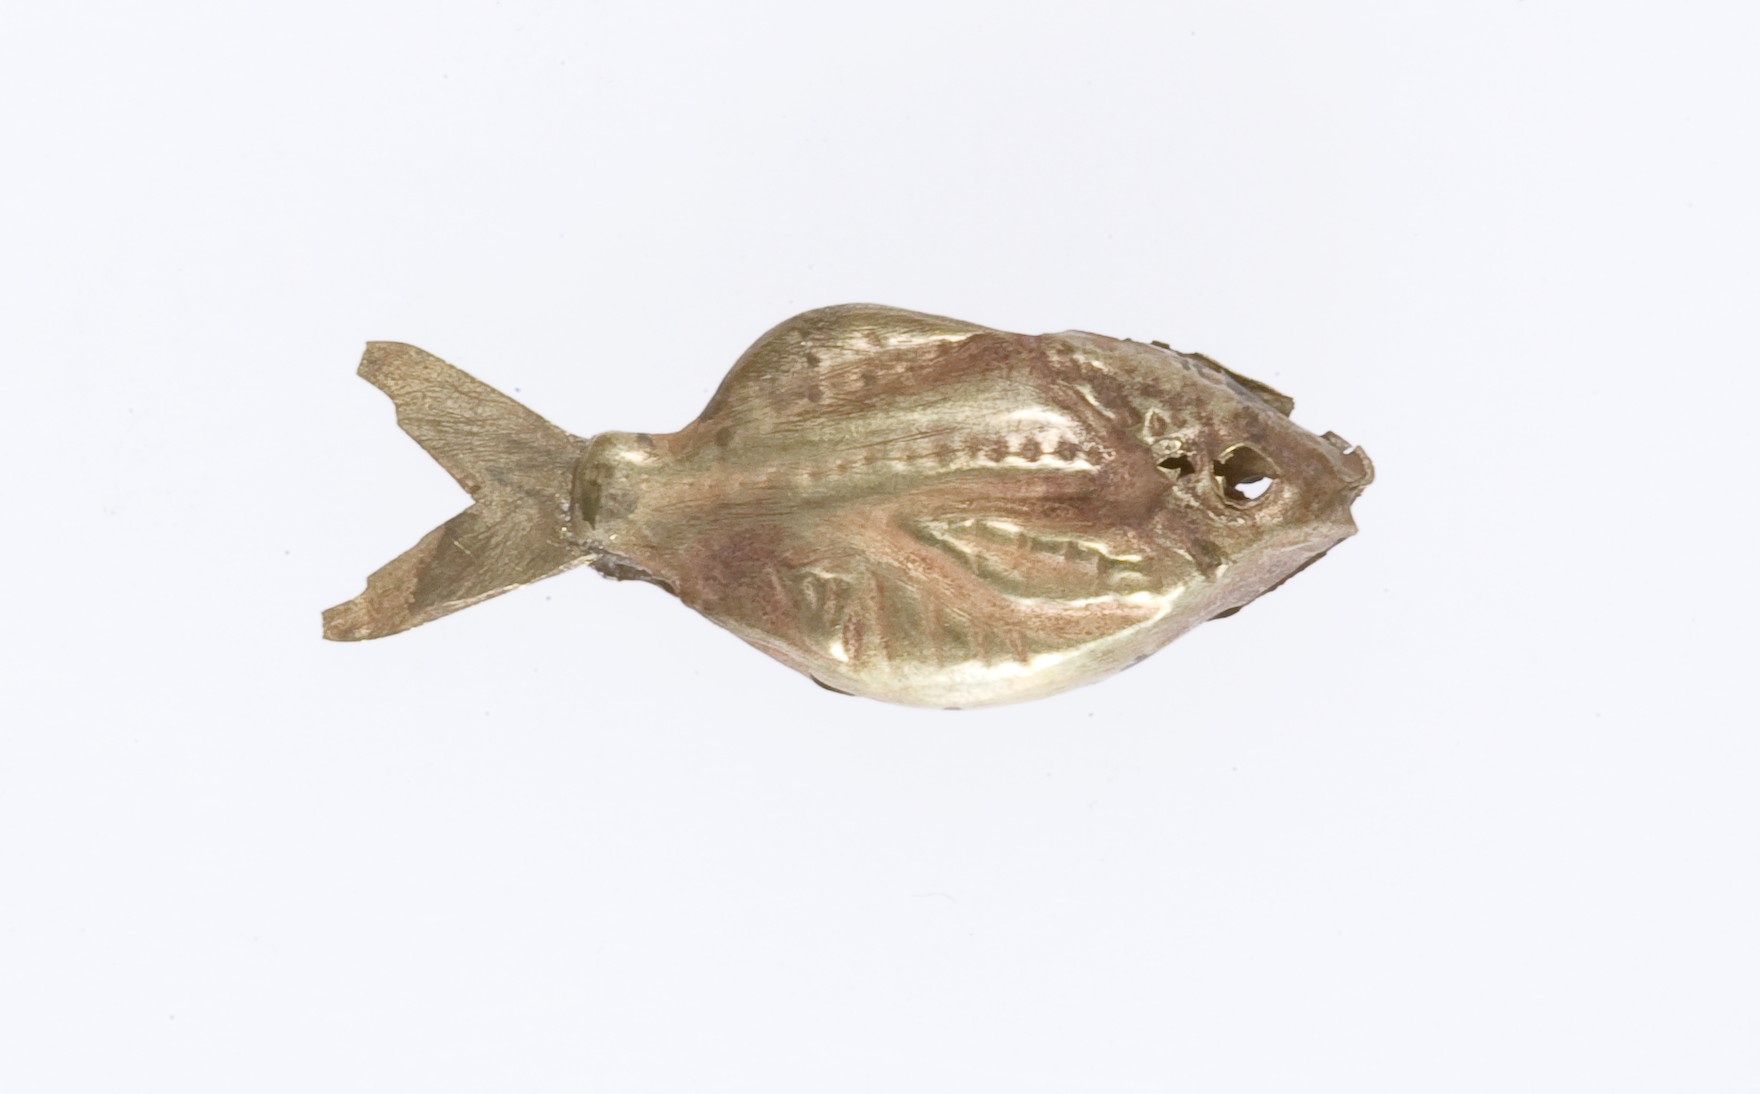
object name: amulet, fish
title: Fish amulet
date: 1981-1640 BCE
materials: gold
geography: egypt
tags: fish